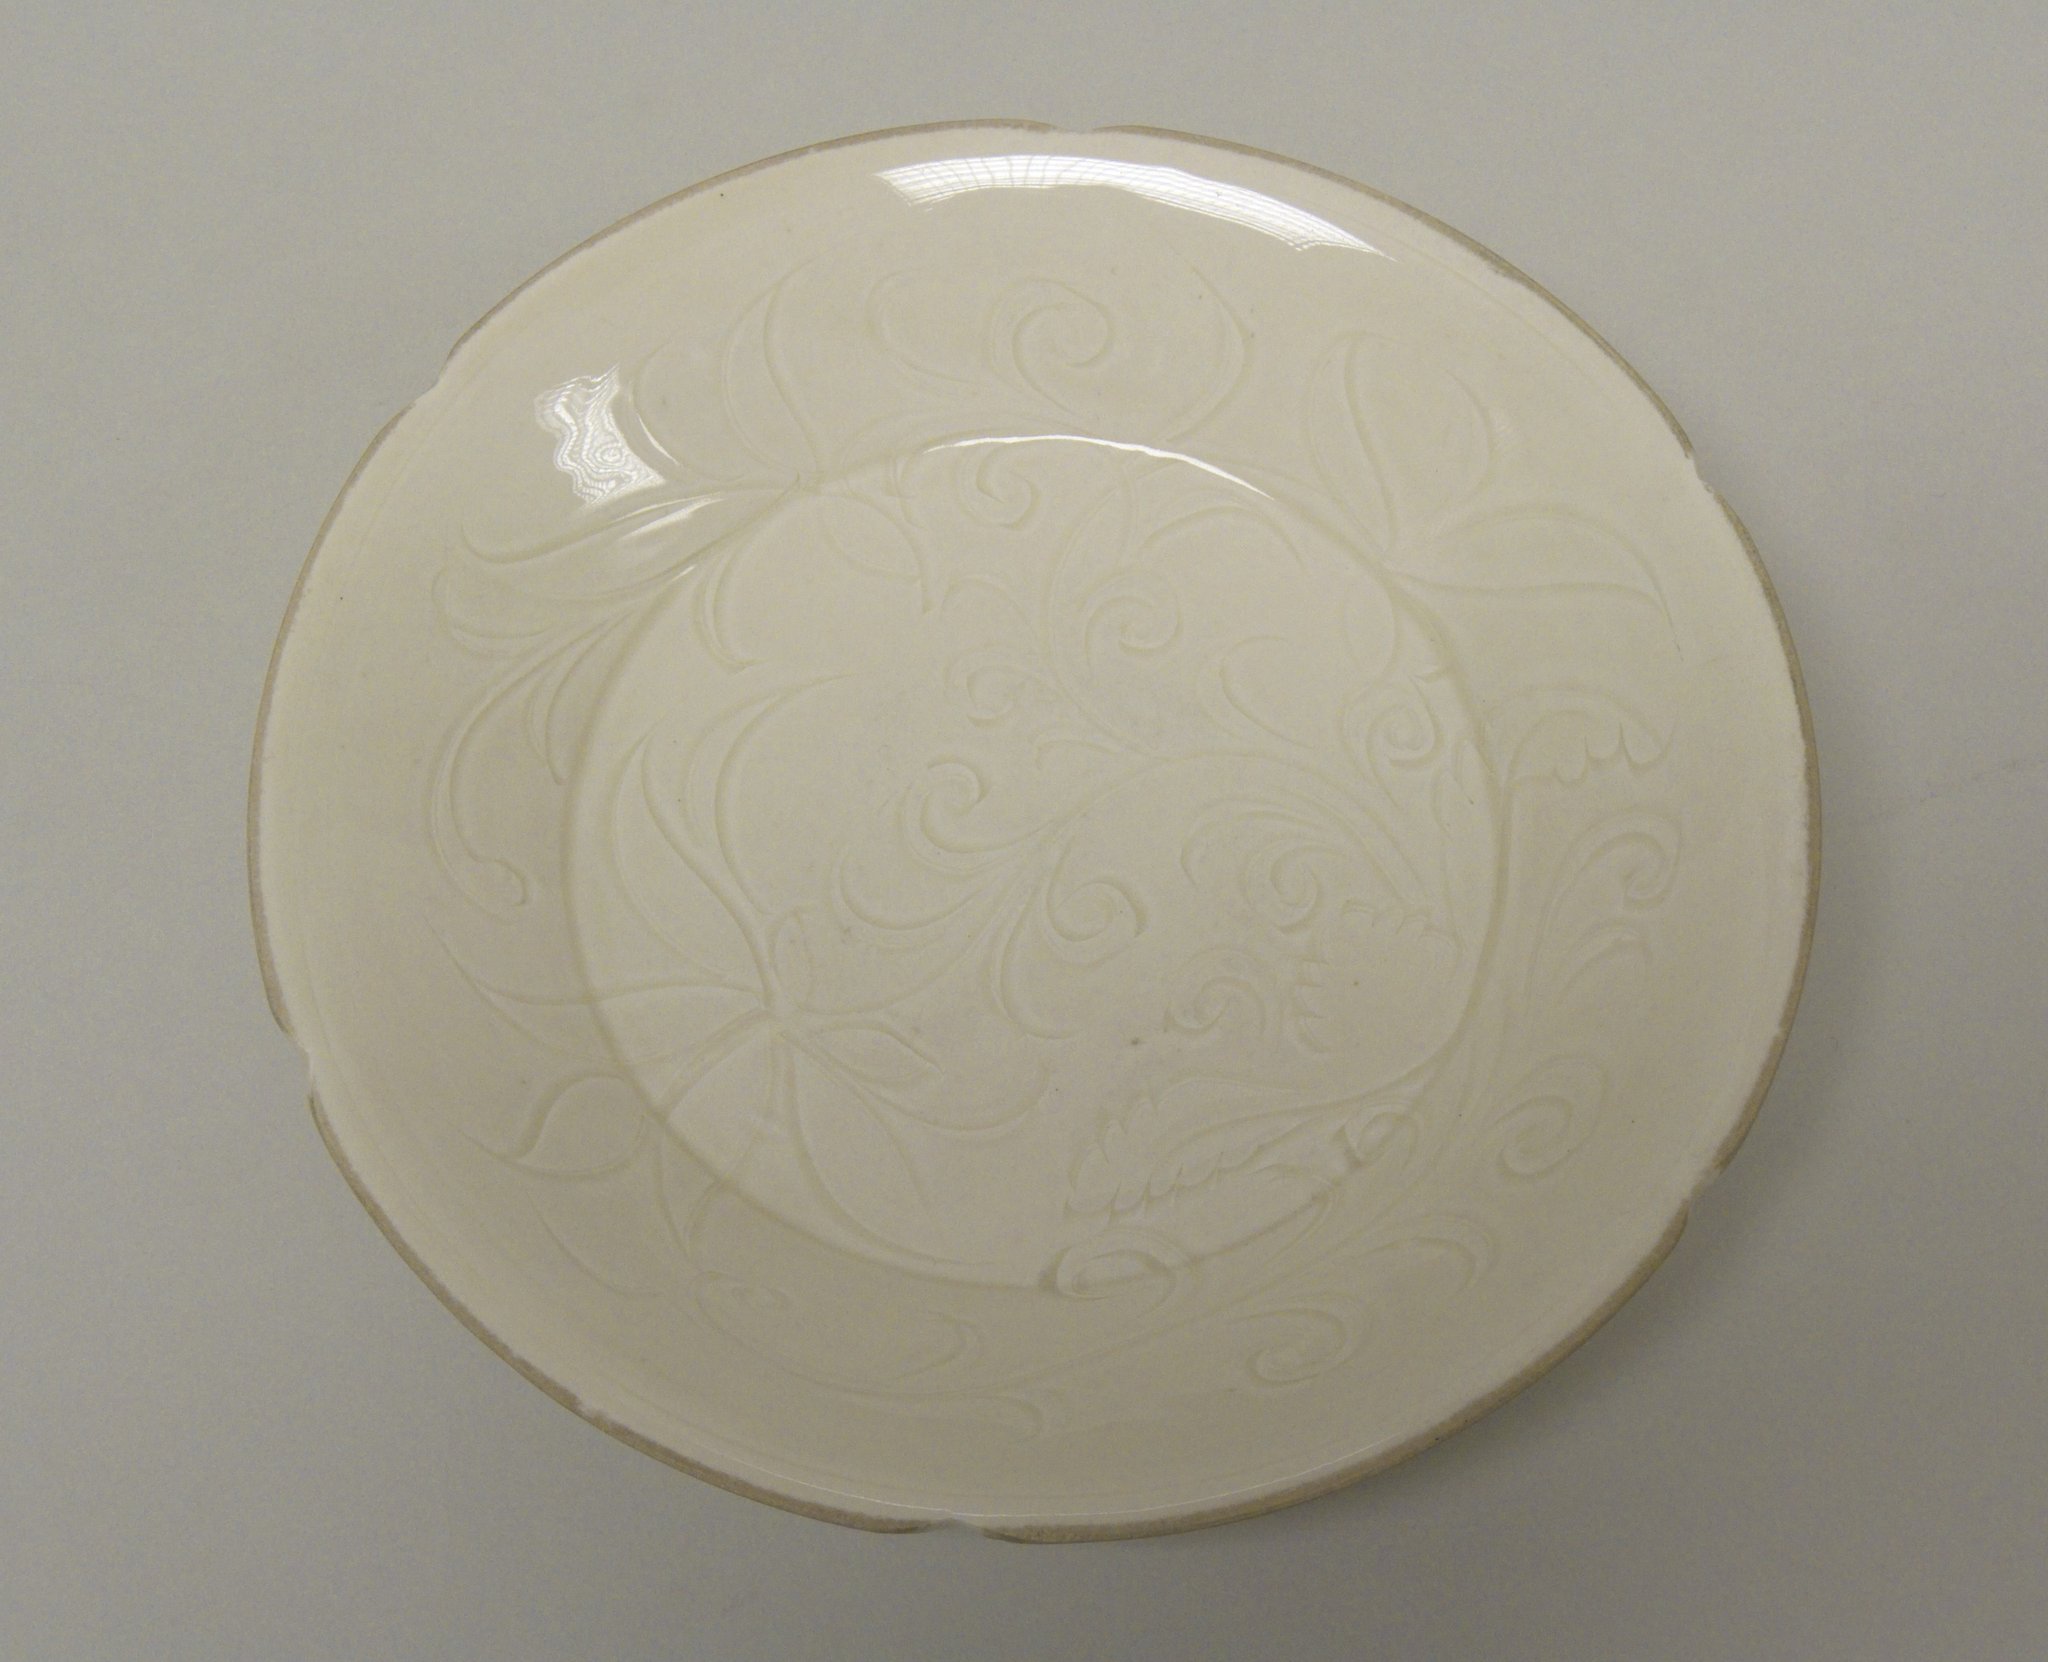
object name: dish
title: Dish with hexafoil rim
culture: chinese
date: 1001-1200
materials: glaze, ivory, porcelain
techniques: incising